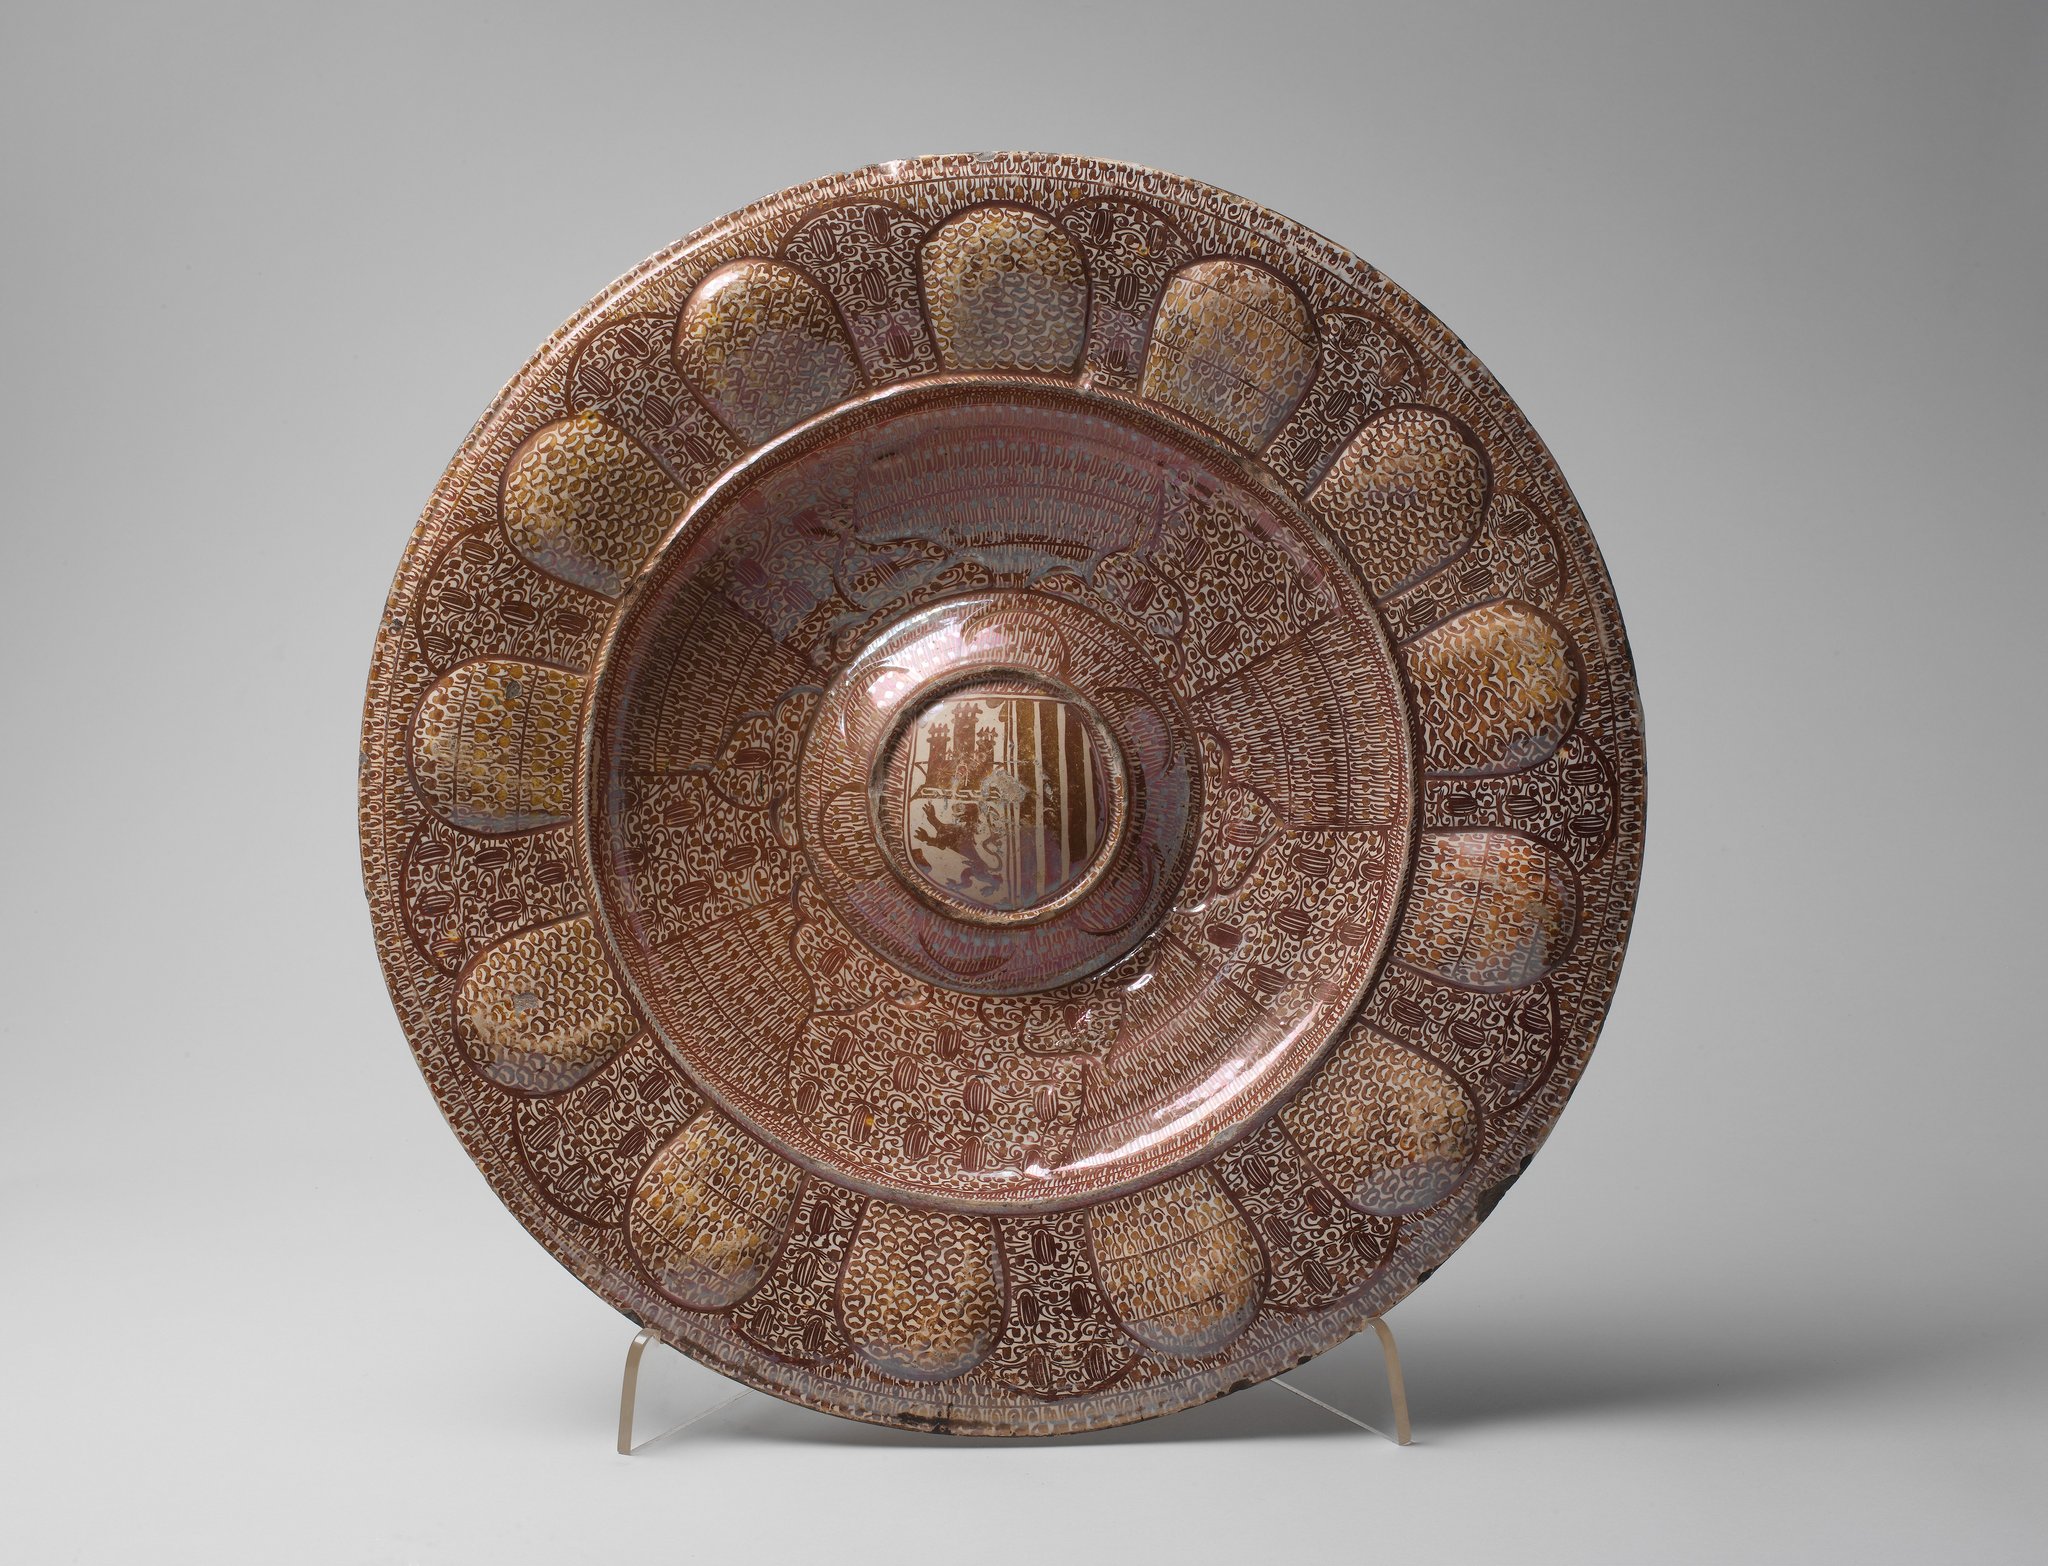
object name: dish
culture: spanish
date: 1467-1533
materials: earthenware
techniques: glazing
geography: spain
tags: coat of arms